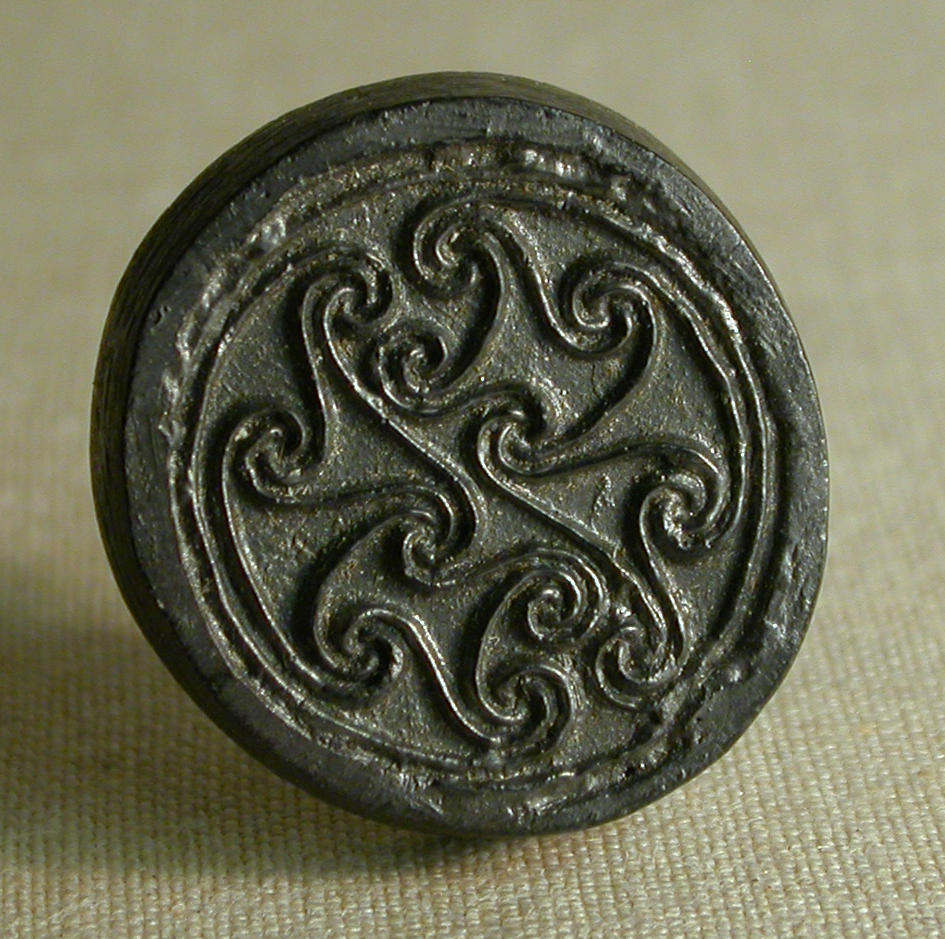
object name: button shaped seal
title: Button-shaped seal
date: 1640-1550 BCE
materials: stone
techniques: glazing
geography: egypt